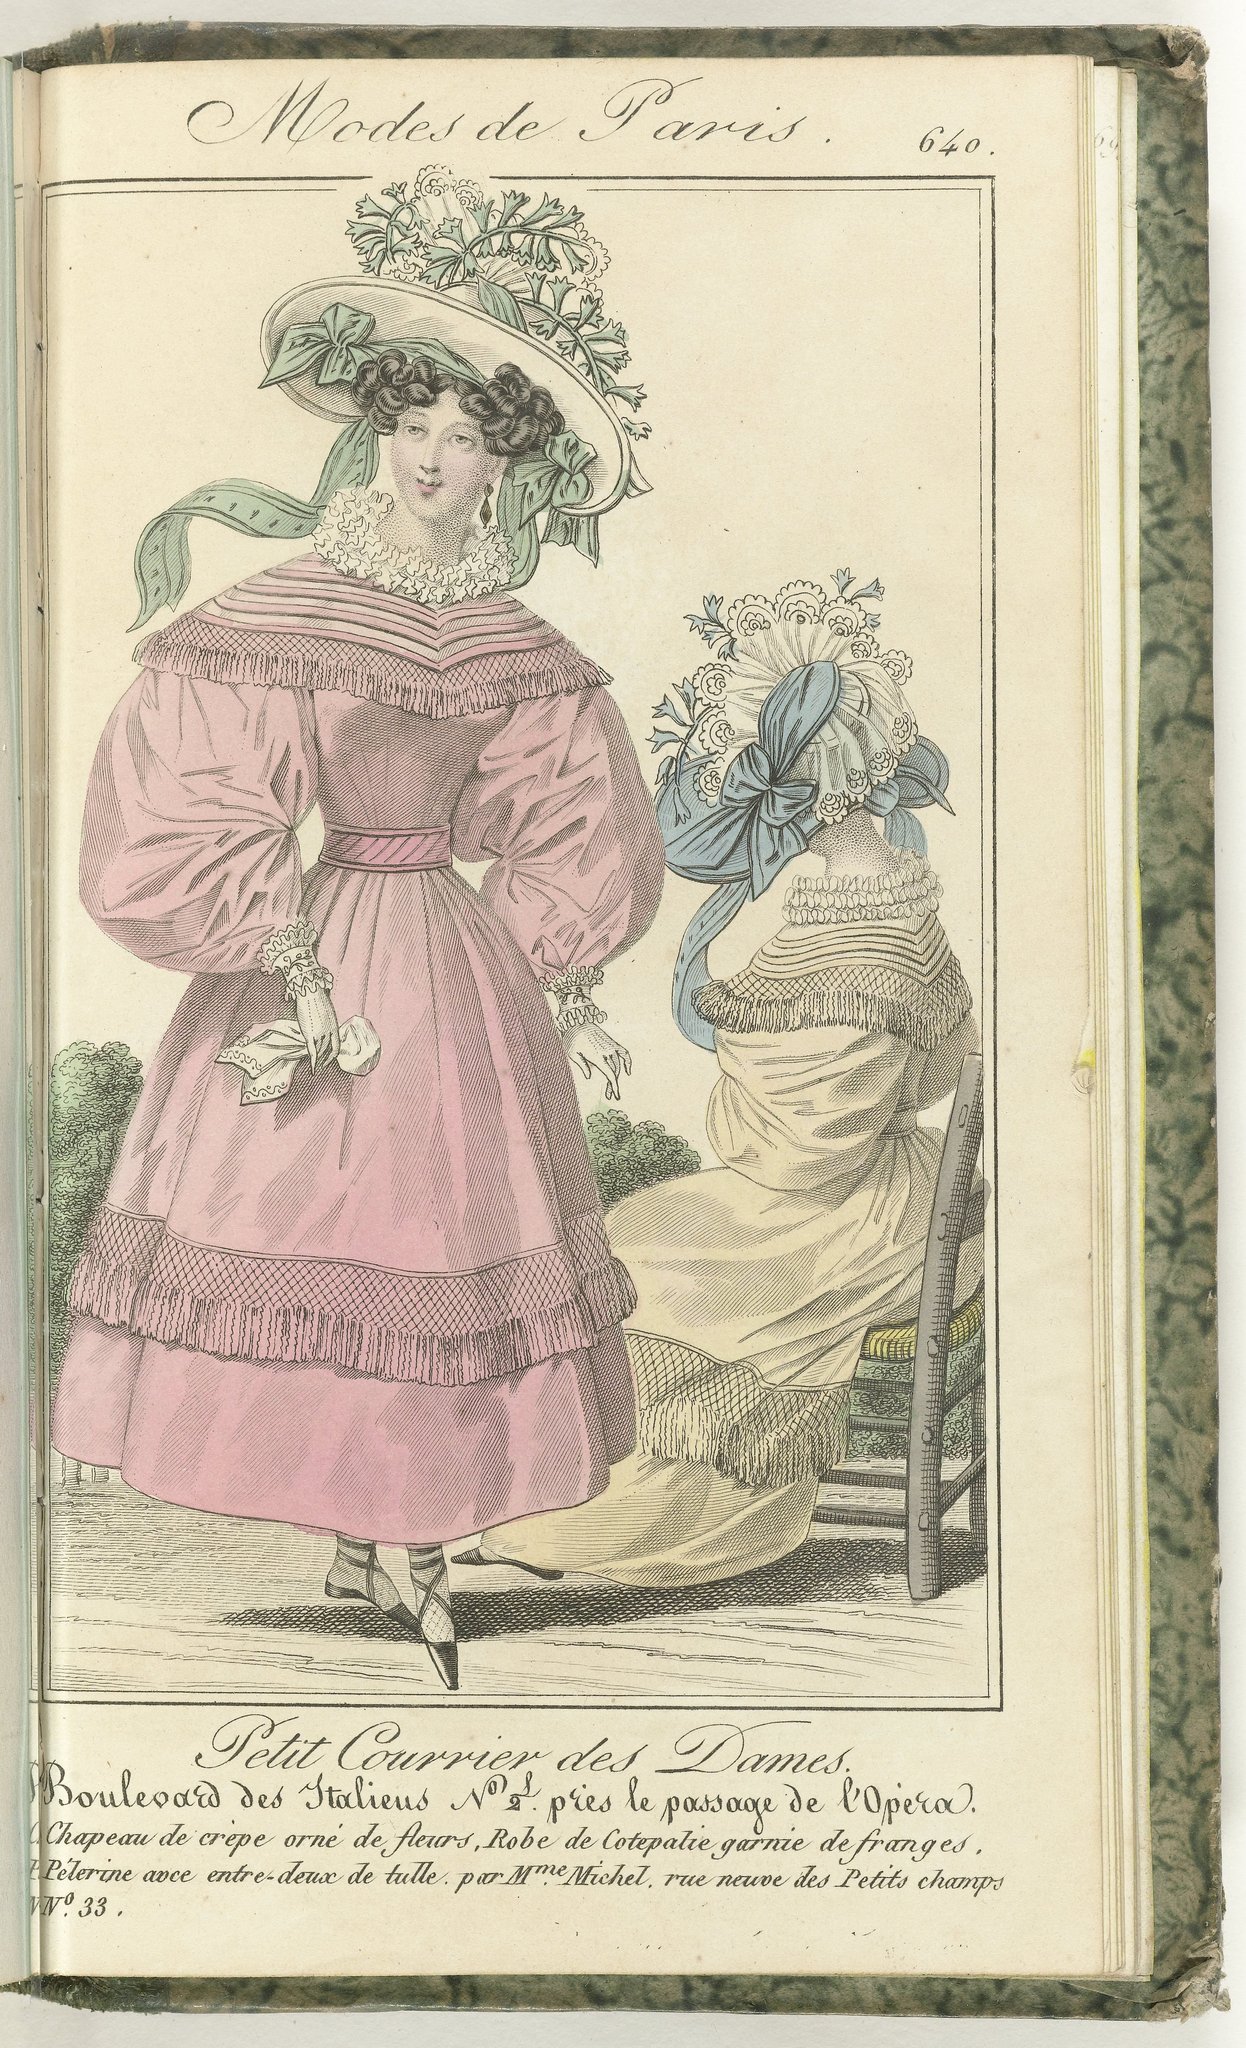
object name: fashion print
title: Petit Courrier des Dames, 25 mai 1829, No. 640 : Chapeau de crèpe...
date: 1829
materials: paper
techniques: engraving, hand coloring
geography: paris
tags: flowers, handkerchief (+ women's clothes), clothing for the upper part of the body (pelerine) (+ women's clothes), fashion plates, head-gear: hat (+ women's clothes), dress, gown (+ women's clothes)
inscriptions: title: ‘Petit Courrier des Dames.’, caption: ‘Chapeau de crèpe orné de fleurs. Robe de Cotepalie garnie de franges. Pélerine avec entre-deux de tulle. par M.me Michel. rue neuve des Petits champs No. 33.’, address: ‘Boulevard des Italiens No.2 près le passage de l'Opèra.’, title: ‘Modes de Paris.’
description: Staande vrouw gekleed in een japon van 'cotepalie' gegarneerd met franjes. Pelerine met entre-deux van tule, door Michel. Hoed van crêpe versierd met bloemen. Zittende figuur, op de rug gezien, gekleed in eenzelfde japon. Prent uit het modetijdschrift Petit Courrier des Dames (1821-1868). Ingebonden (met enkele pag. Le Journal des Dames et des Modes). 15 Januari 1827 t/m 20 maart 1830. Incompleet.